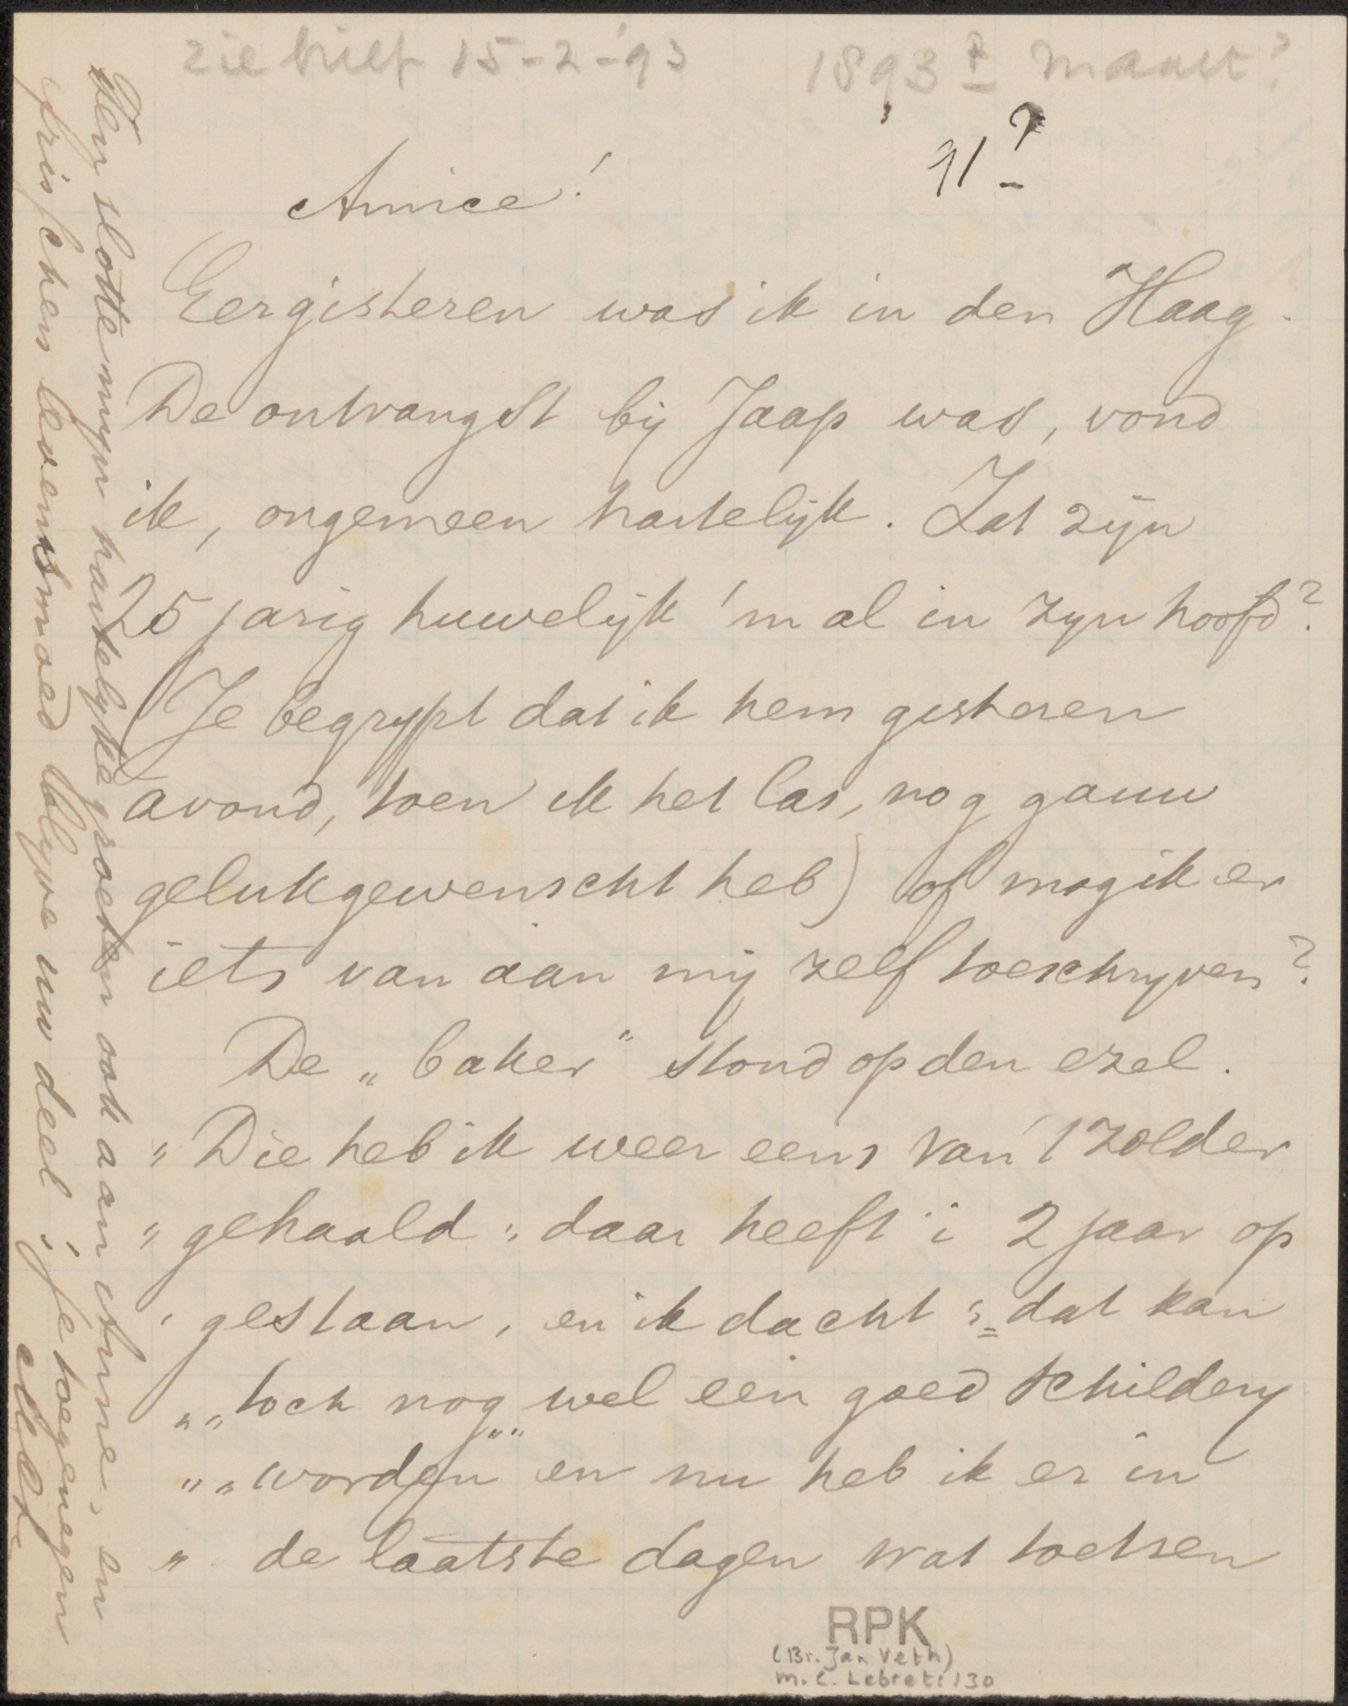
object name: letter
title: Brief aan Jan Veth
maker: martinus cornelis lebret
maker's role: verzamelaar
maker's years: 1833-1894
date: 1874-1894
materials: ink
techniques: pen, writing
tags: jan veth, painter, print maker, draughtsman, jacob maris, painting (including book-illumination, miniature-painting), diseases, art collecting, the hague, paris, amsterdam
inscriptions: collector's mark: ‘RPK’